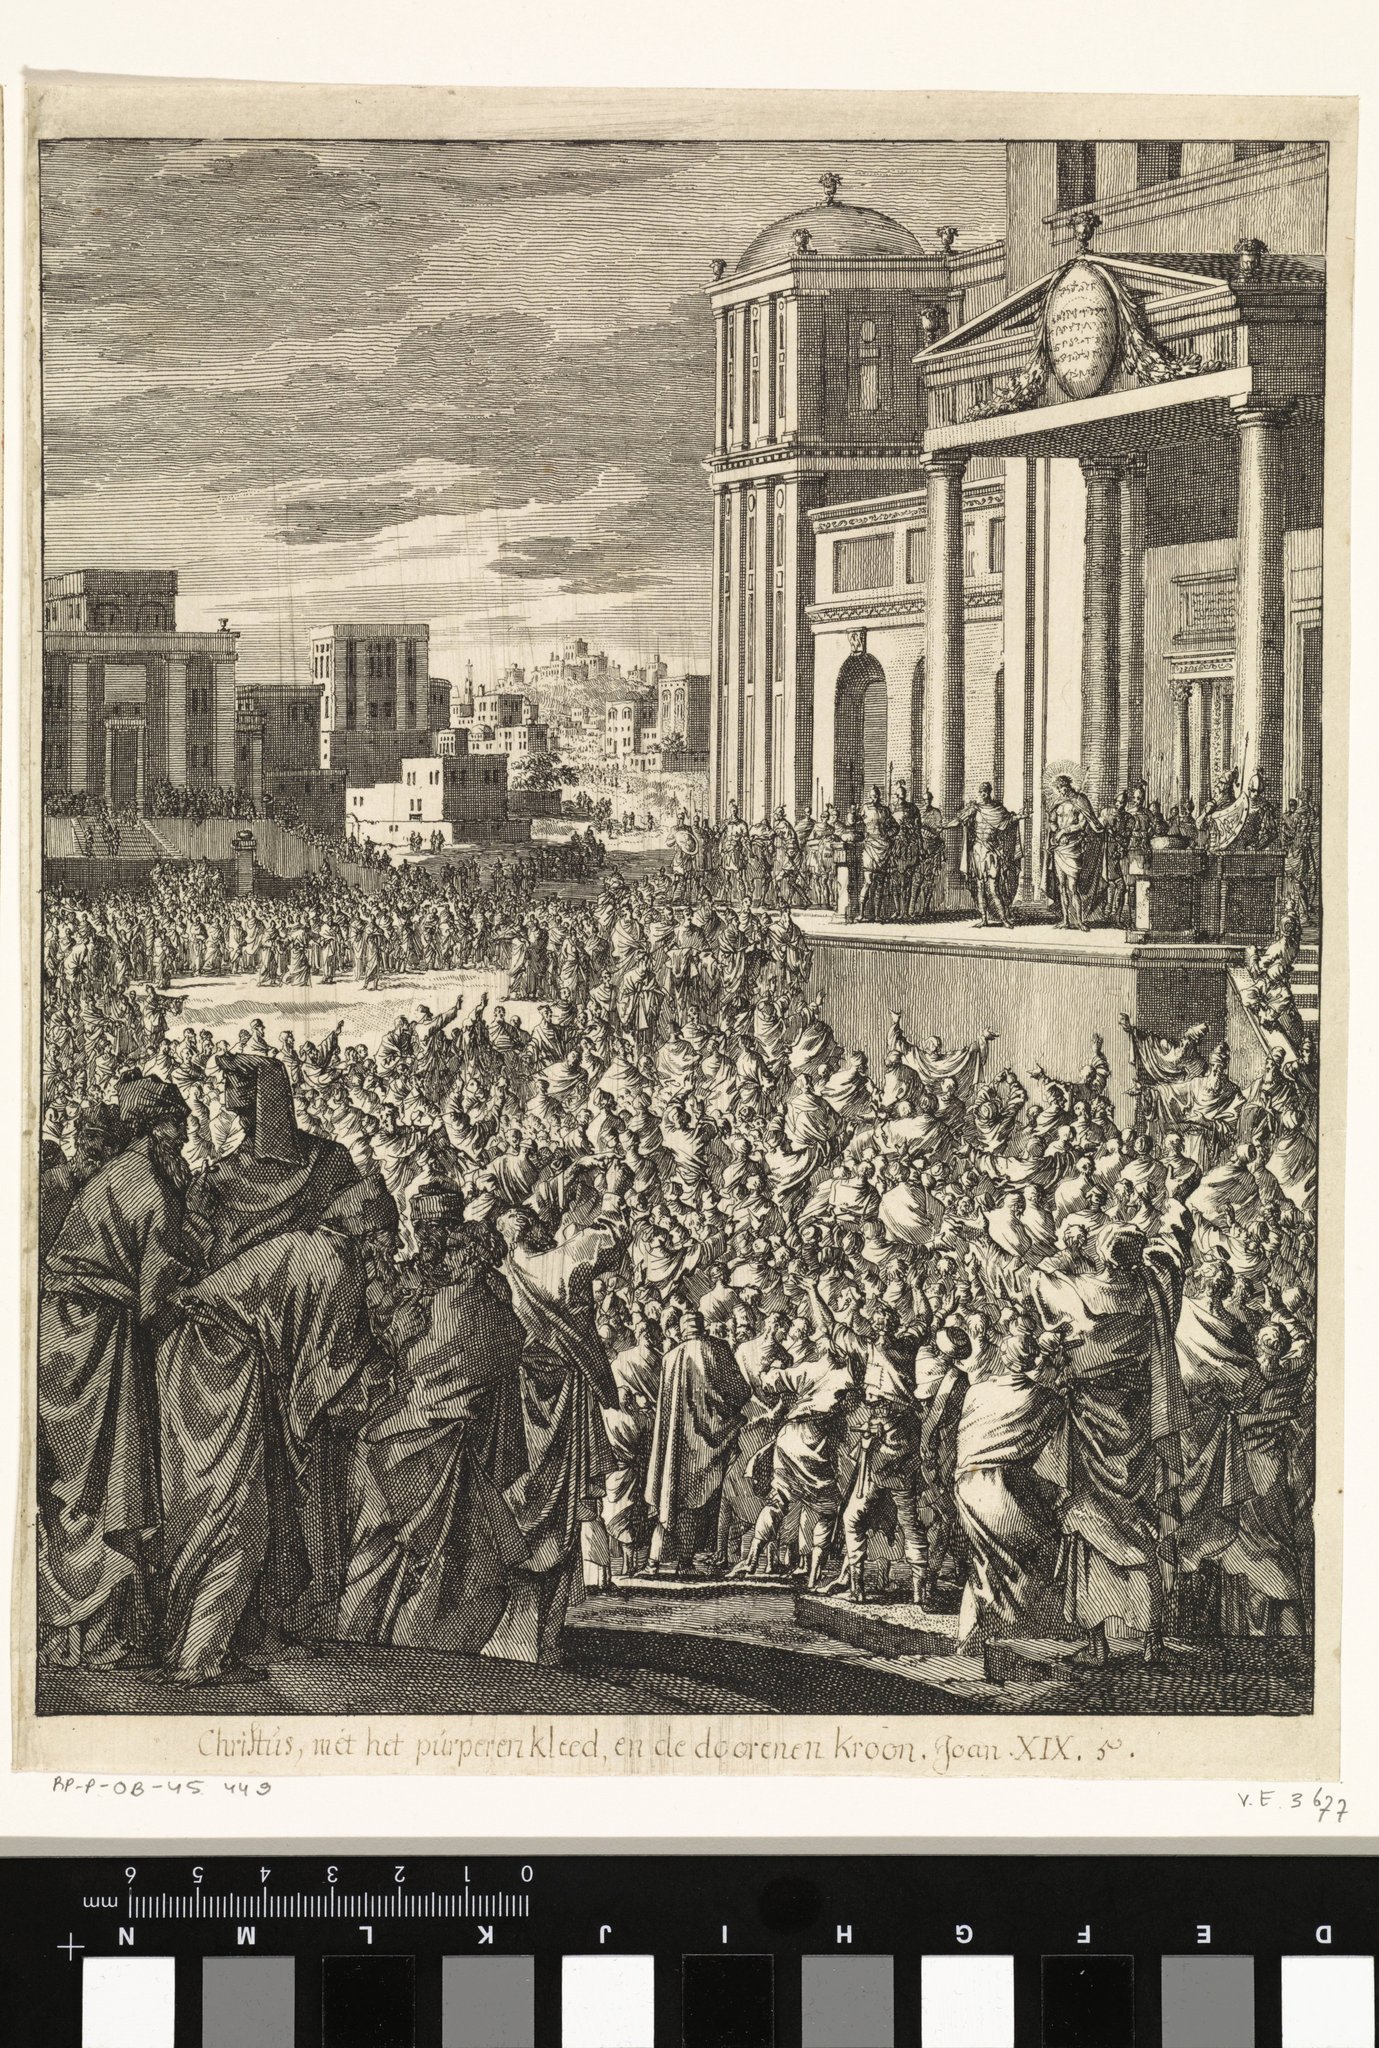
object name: print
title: Christus aan het volk getoond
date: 1708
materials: paper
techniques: etching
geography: amsterdam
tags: pilate showing christ to the people, 'ostentatio christi', 'ecce homo' (john 19:4-6)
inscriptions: collector's mark: Lugt 2228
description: Proefdruk van een prent welke is opgenomen als illustratie in: Historiae Celebriores Veteris Testamenti. Christoph Weigel, 1708.